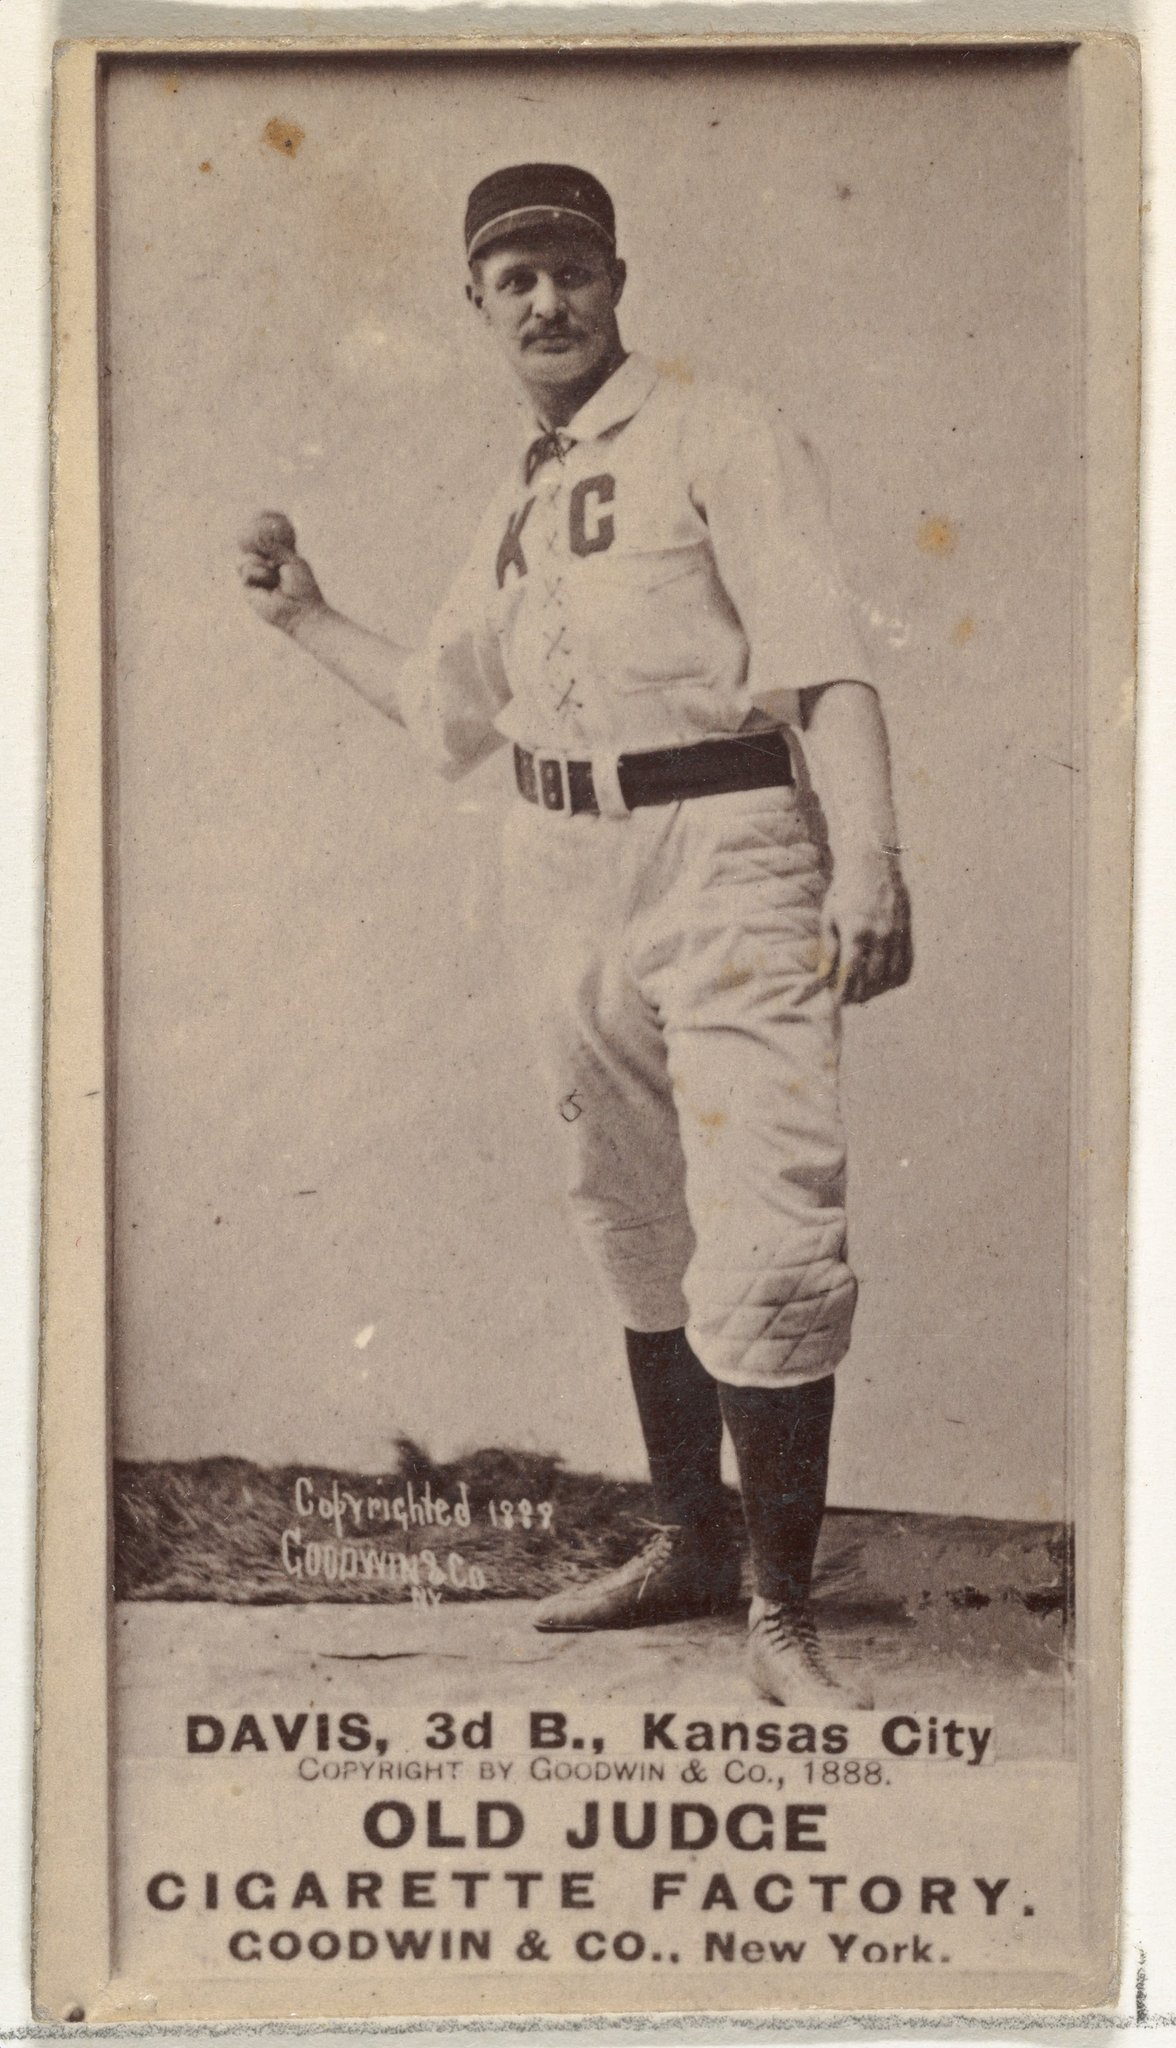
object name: baseball card, photograph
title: James J. "Jumbo" Davis, 3rd Base, Kansas City Cowboys, from the Old Judge series (N172) for Old Judge Cigarettes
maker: goodwin & company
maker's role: publisher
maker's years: 1850-1950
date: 1888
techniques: albumen silver print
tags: men,portraits,baseball,athletes